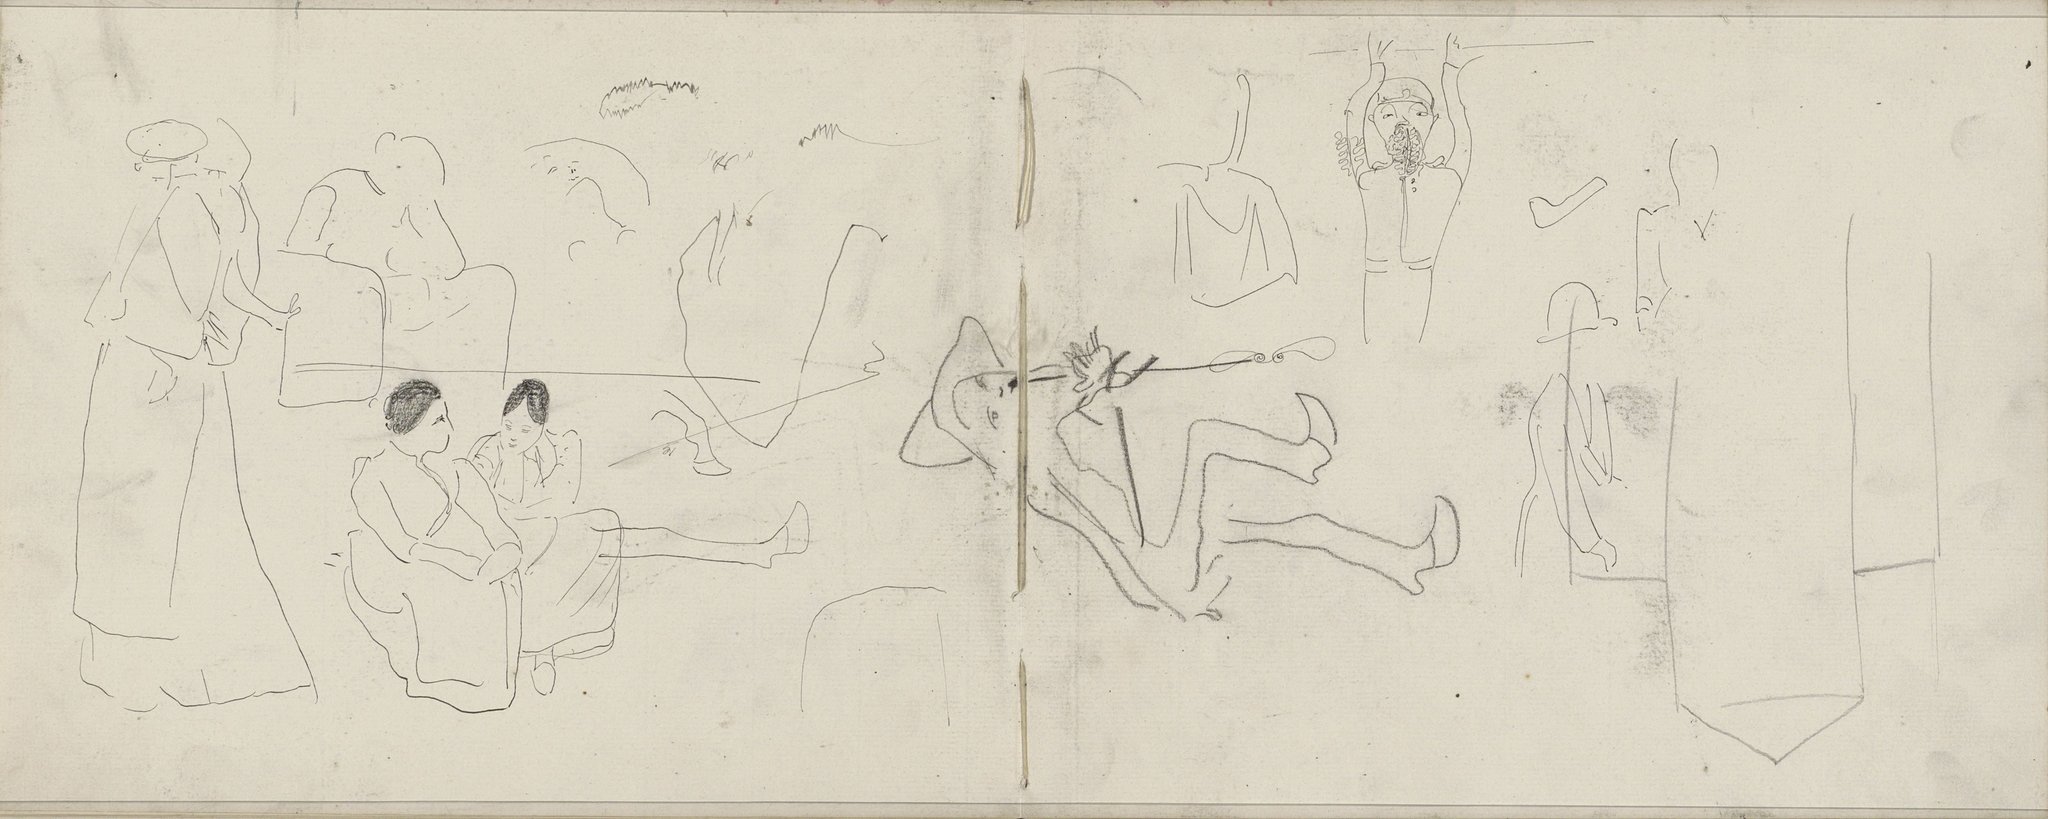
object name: sketchbook leaf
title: Figuurstudies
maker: carel adolph lion cachet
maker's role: draughtsman, print maker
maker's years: 1864-1945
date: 1896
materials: chalk, ink, paper, pencil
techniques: pen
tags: sitting figure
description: Onder andere zittende vrouwen en een figuur met een hoed. Blad 18 verso en 19 recto uit een schetsboek met 44 bladen.